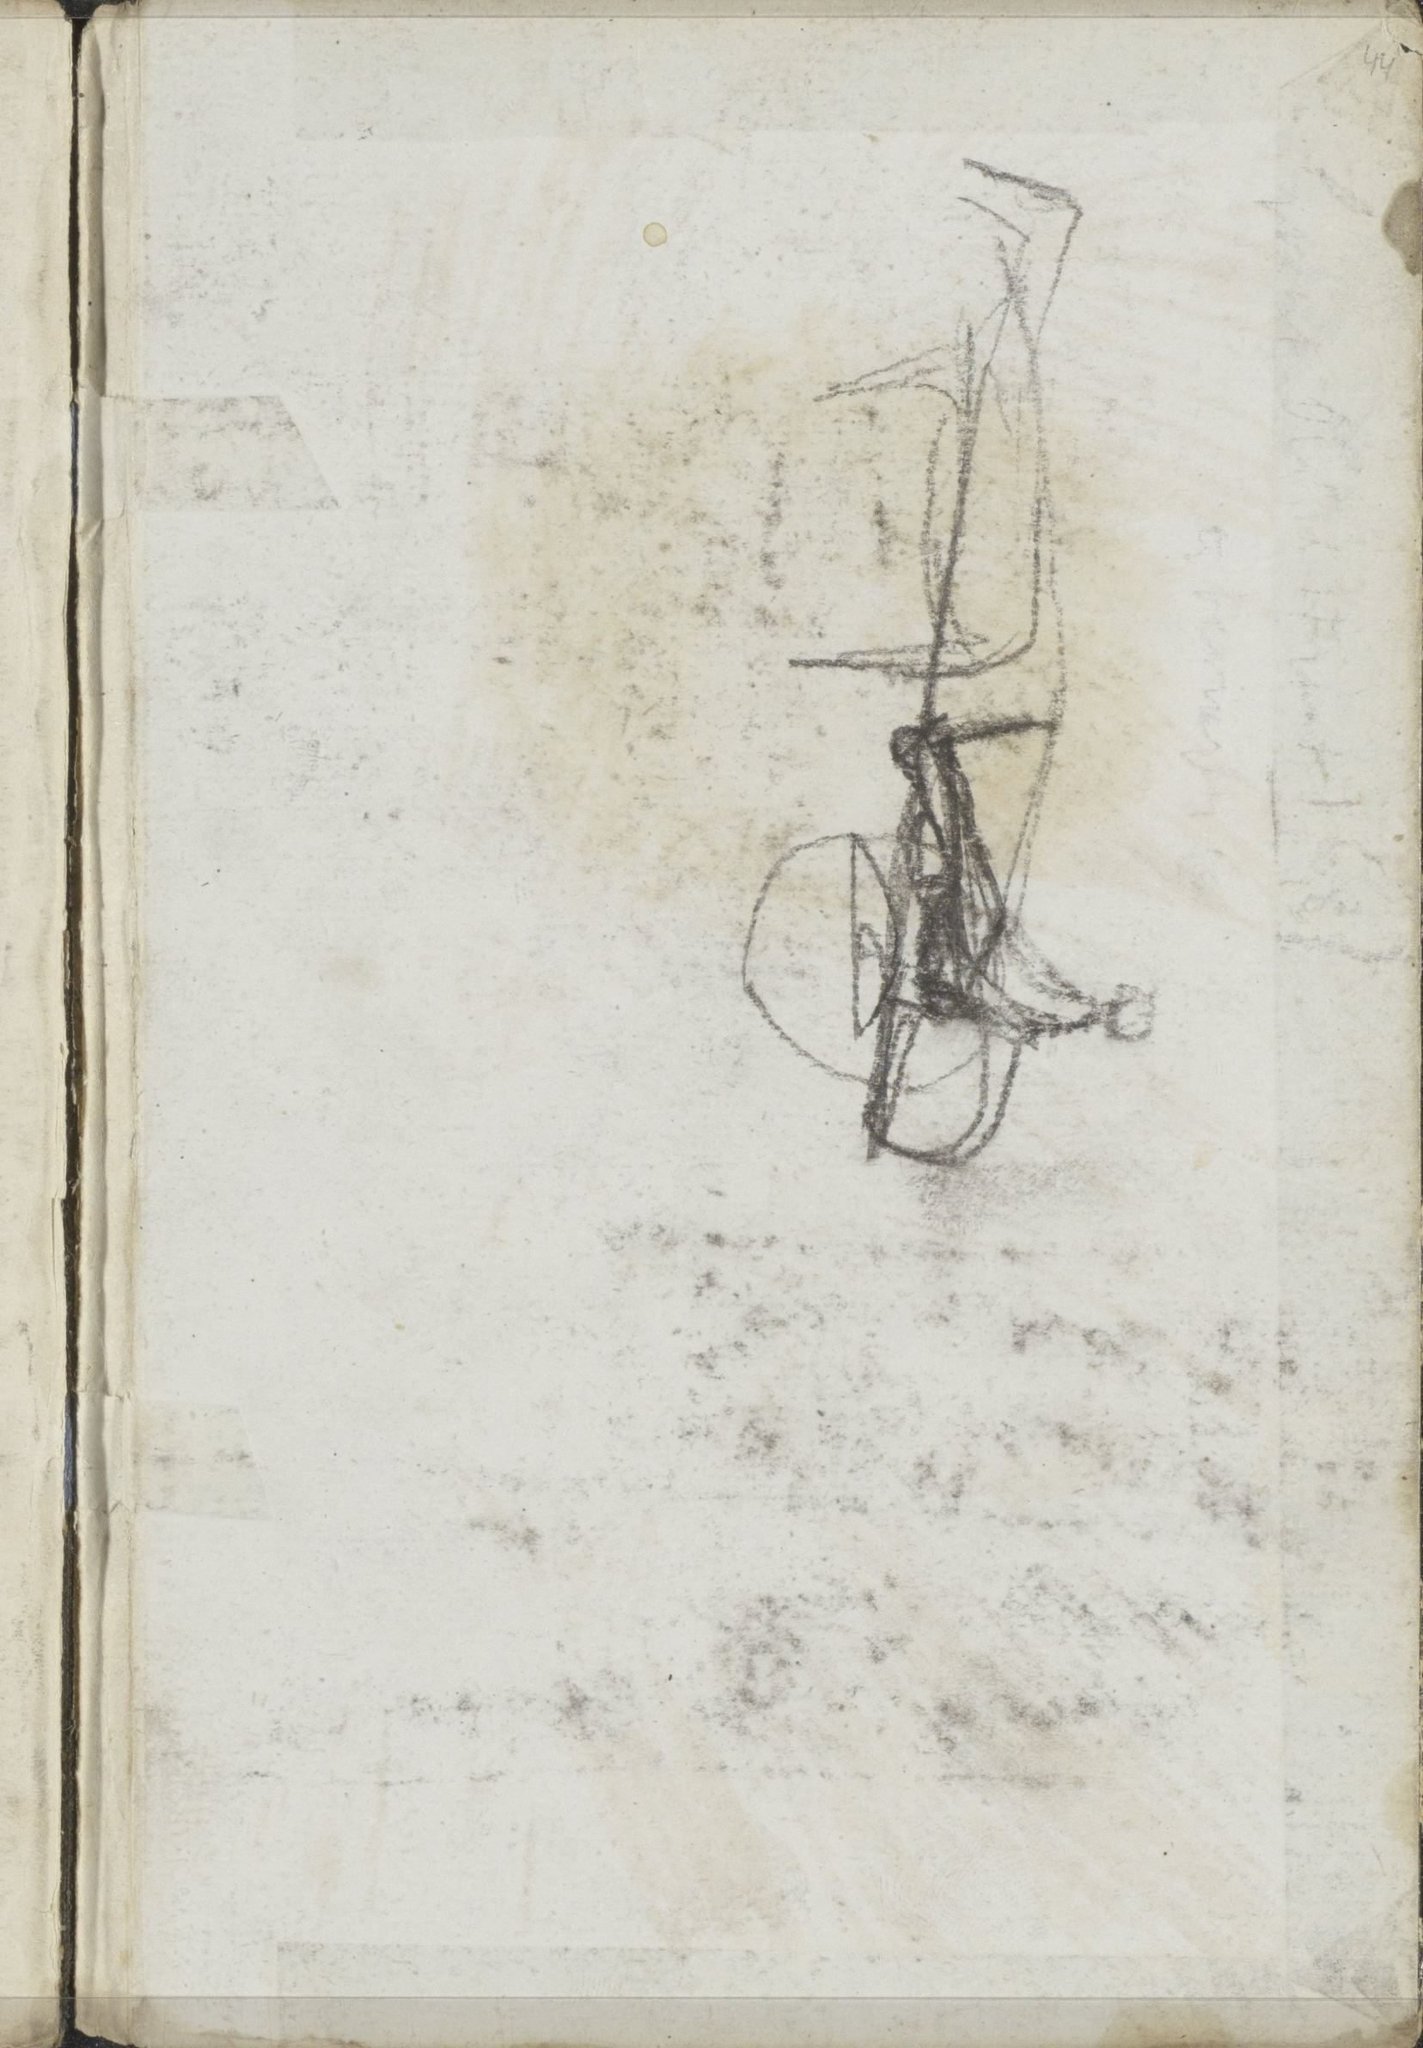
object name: sketchbook leaf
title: Figuur op een paardenkar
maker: george hendrik breitner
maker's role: draughtsman, painter, print maker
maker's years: 1857-1923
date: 1886-1898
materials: chalk, paper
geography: amsterdam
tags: (farm) wagon, freight wagon, cart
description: Pagina 44, achterste schutblad, uit een schetsboek met 21 bladen.